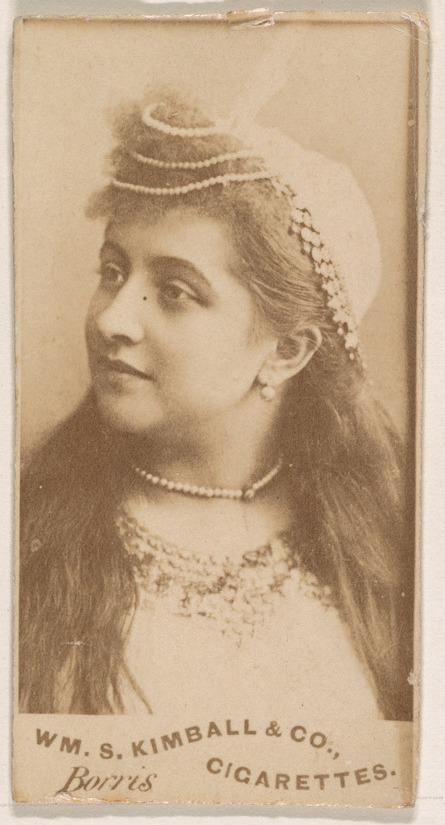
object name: photograph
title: Miss Borris, from the Actresses series (N203) issued by Wm. S. Kimball & Co.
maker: william s. kimball & company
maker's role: publisher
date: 1889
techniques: color lithograph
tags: portraits,women,actresses